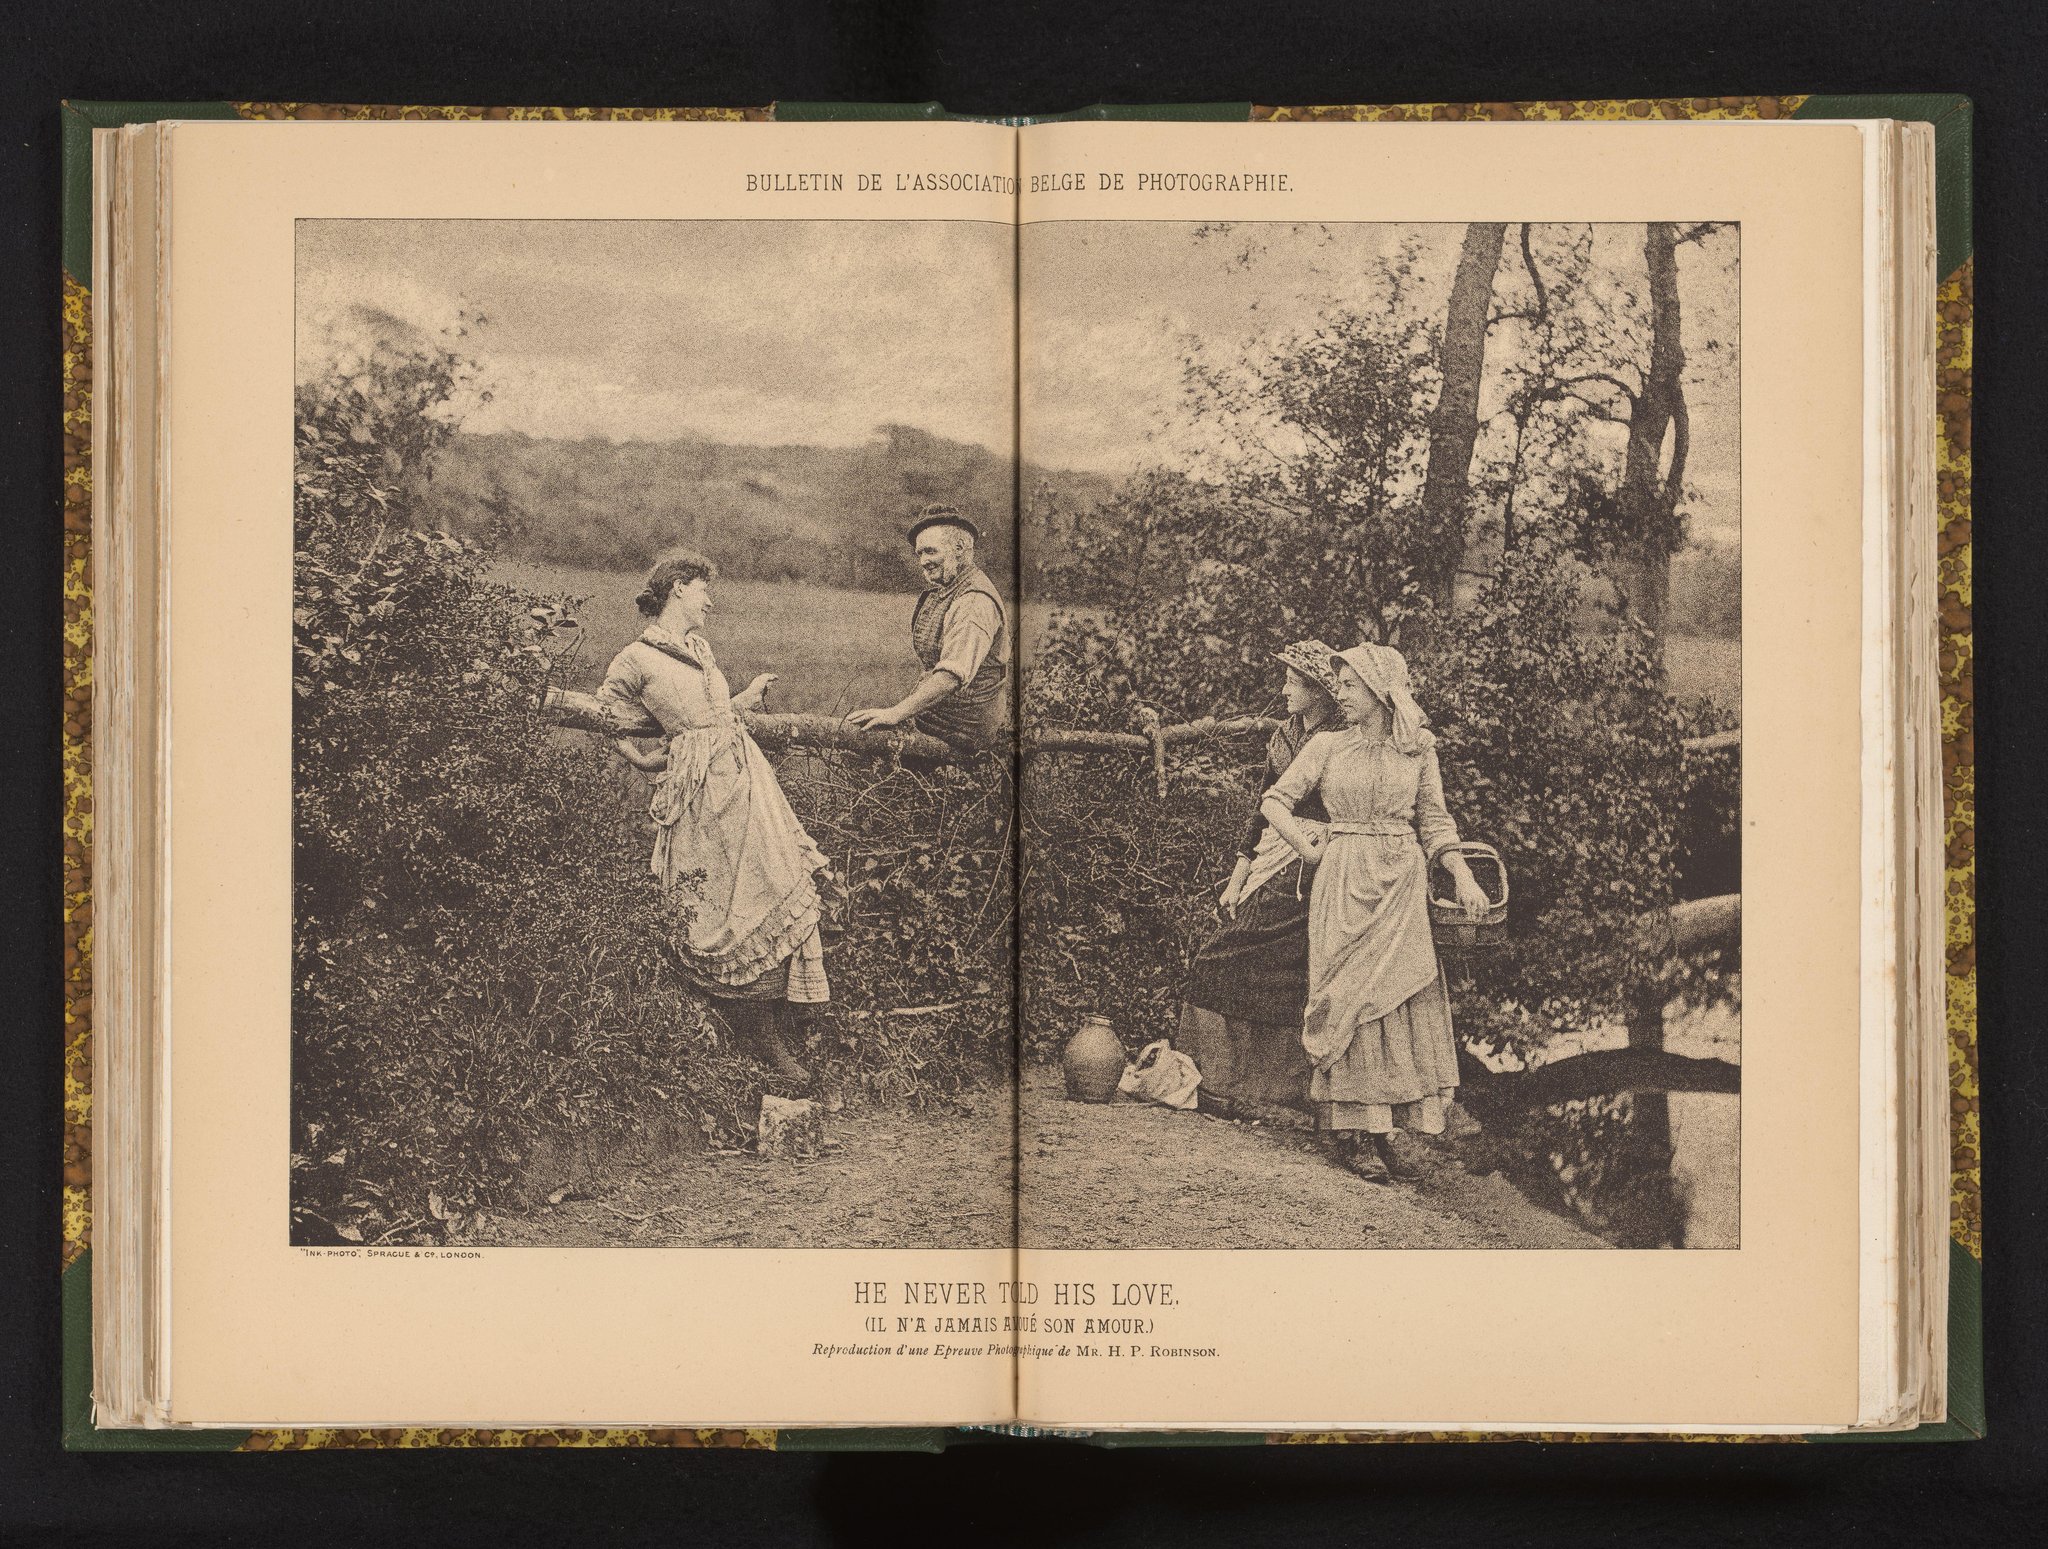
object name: page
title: Drie vrouwen pratend met een man zittend op een boomstronk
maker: henry peach robinson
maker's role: fotograaf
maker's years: 1830-1901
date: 1880-1885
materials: paper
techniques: photolithography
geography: london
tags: trees, lovers; courting, flirting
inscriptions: inscription: ‘"Ink-photo ". Sprague & Co, London.’